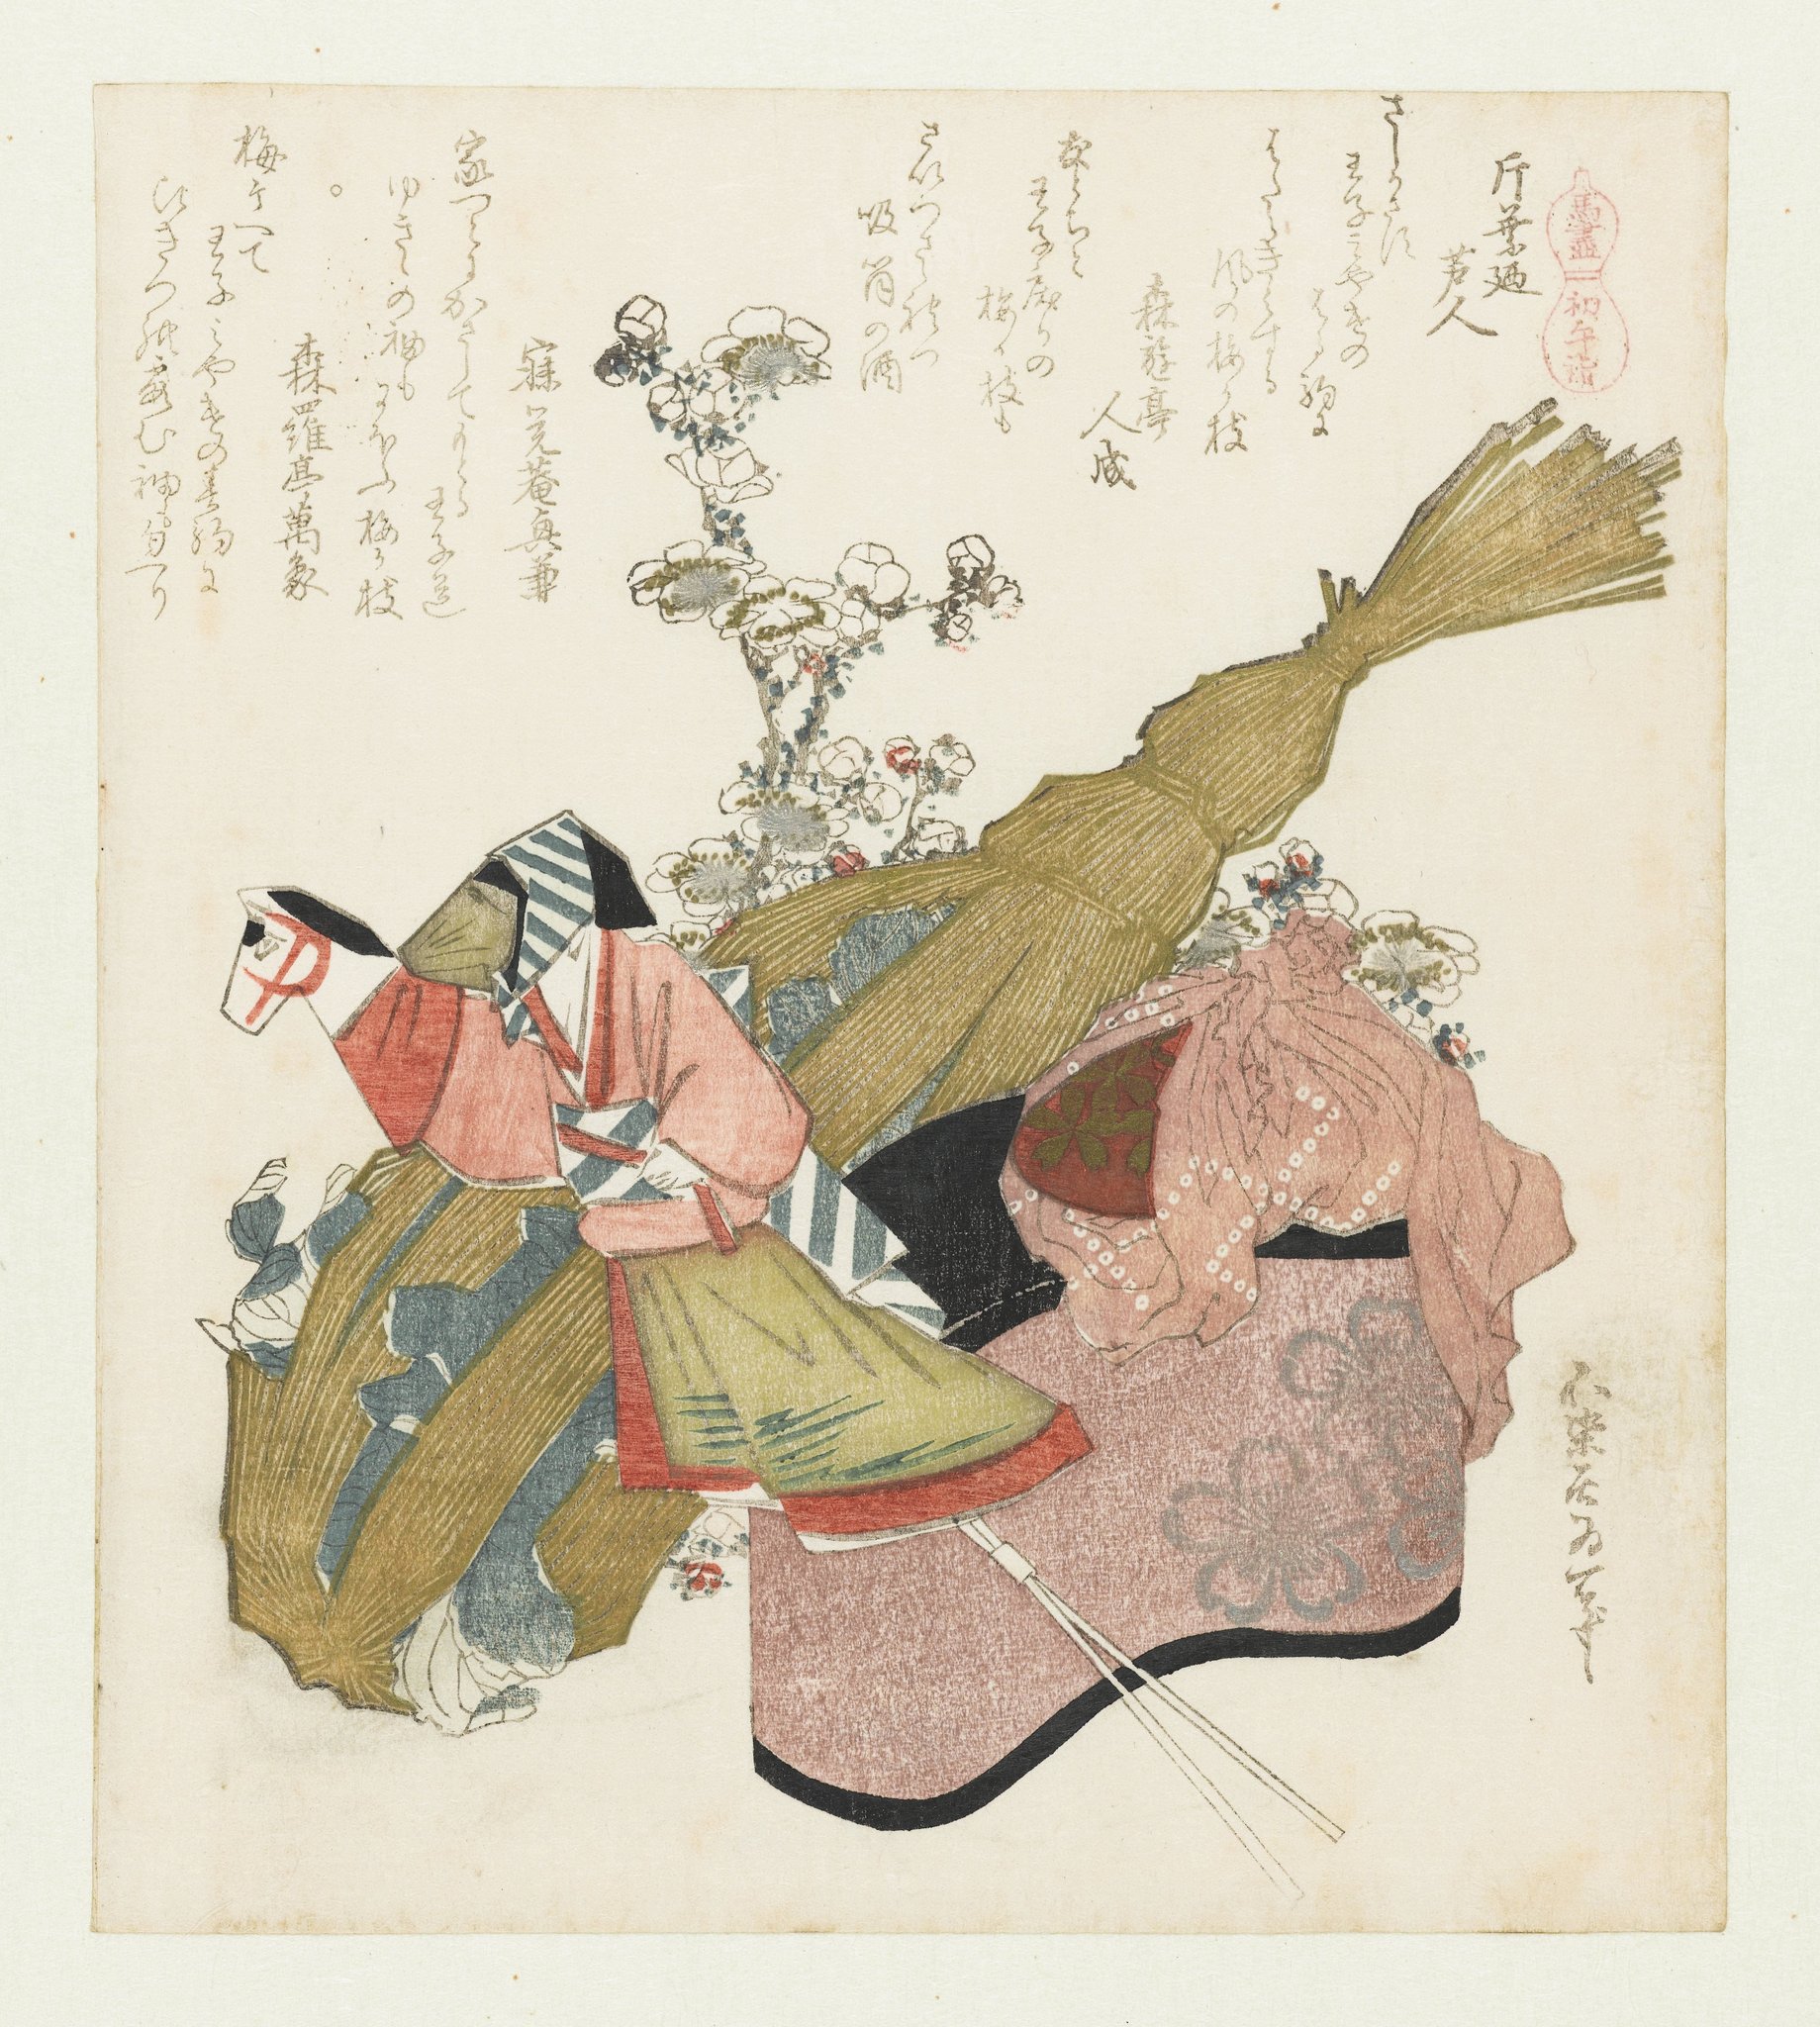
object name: surimono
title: Umazukushi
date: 1822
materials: paper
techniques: woodcut, polish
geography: japan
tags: horse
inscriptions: collector's mark, verso, stamped: Lugt 2228, collector's mark, passe-partout, bottom left, printed: JABdH with a rooster.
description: Een surimono is een luxe uitgevoerde prent waarop beeld met één of meerdere gedichten gecombineerd is. Bij het drukken van een surimono werd vaak gebruik gemaakt van dikker papier, blinddruk en metaal pigmenten, zoals koper- en zilverpoeder. De prenten werden vaak in opdracht van dichters gemaakt en als exclusief geschenk aan vrienden en relaties gegeven.